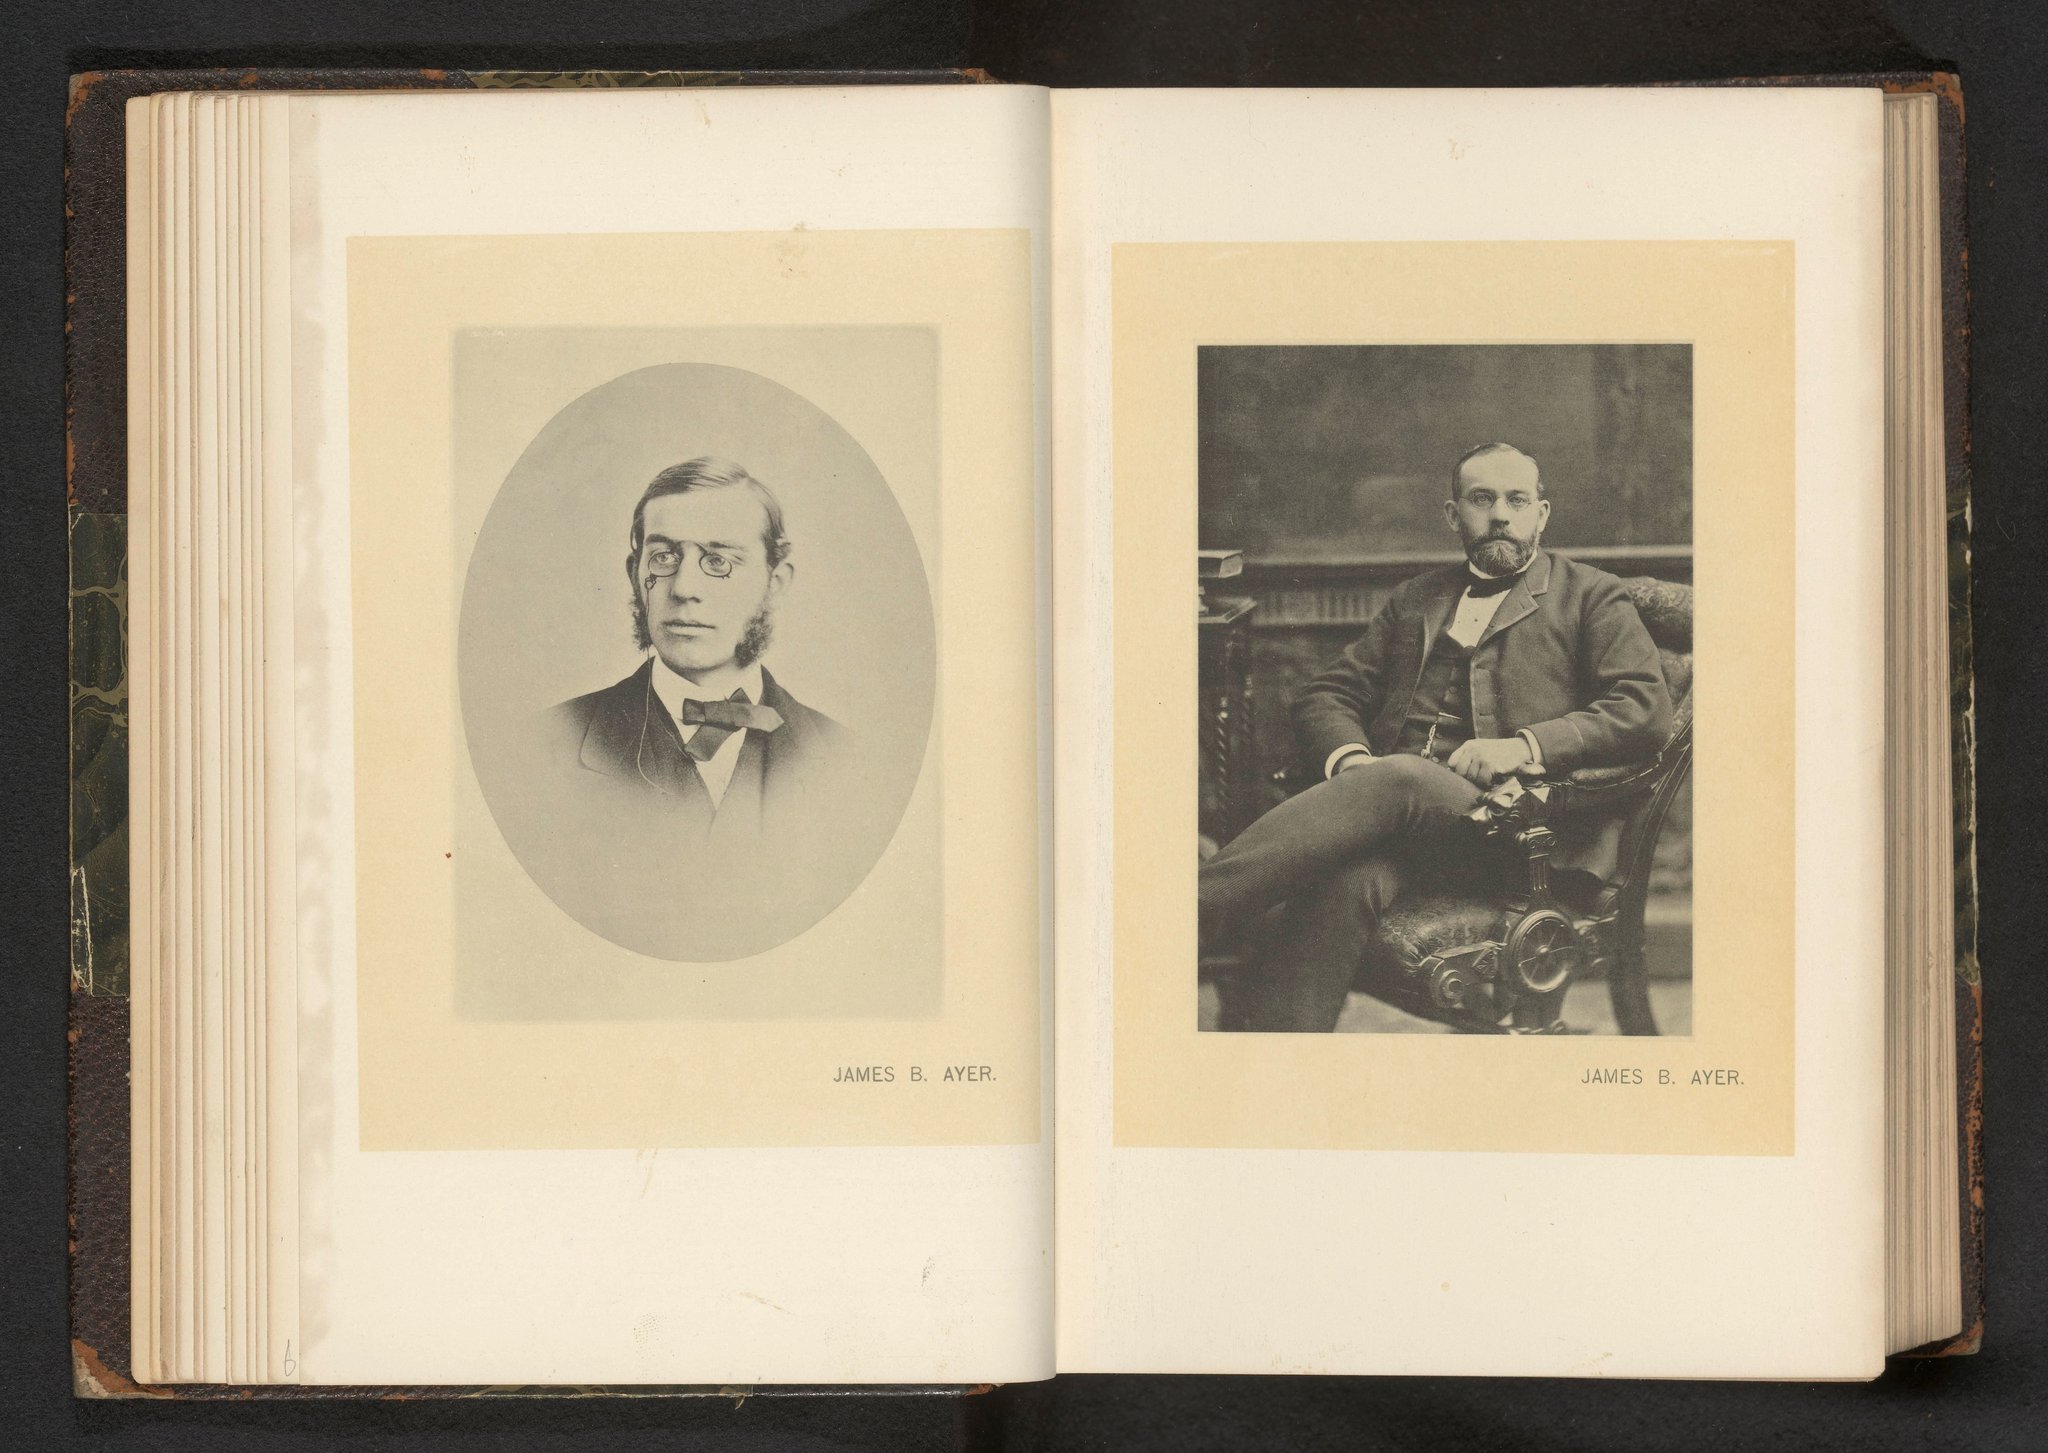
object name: photomechanical print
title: James B. Ayer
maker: Anonymous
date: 1869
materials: paper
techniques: photoaquatint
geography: boston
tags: adult man